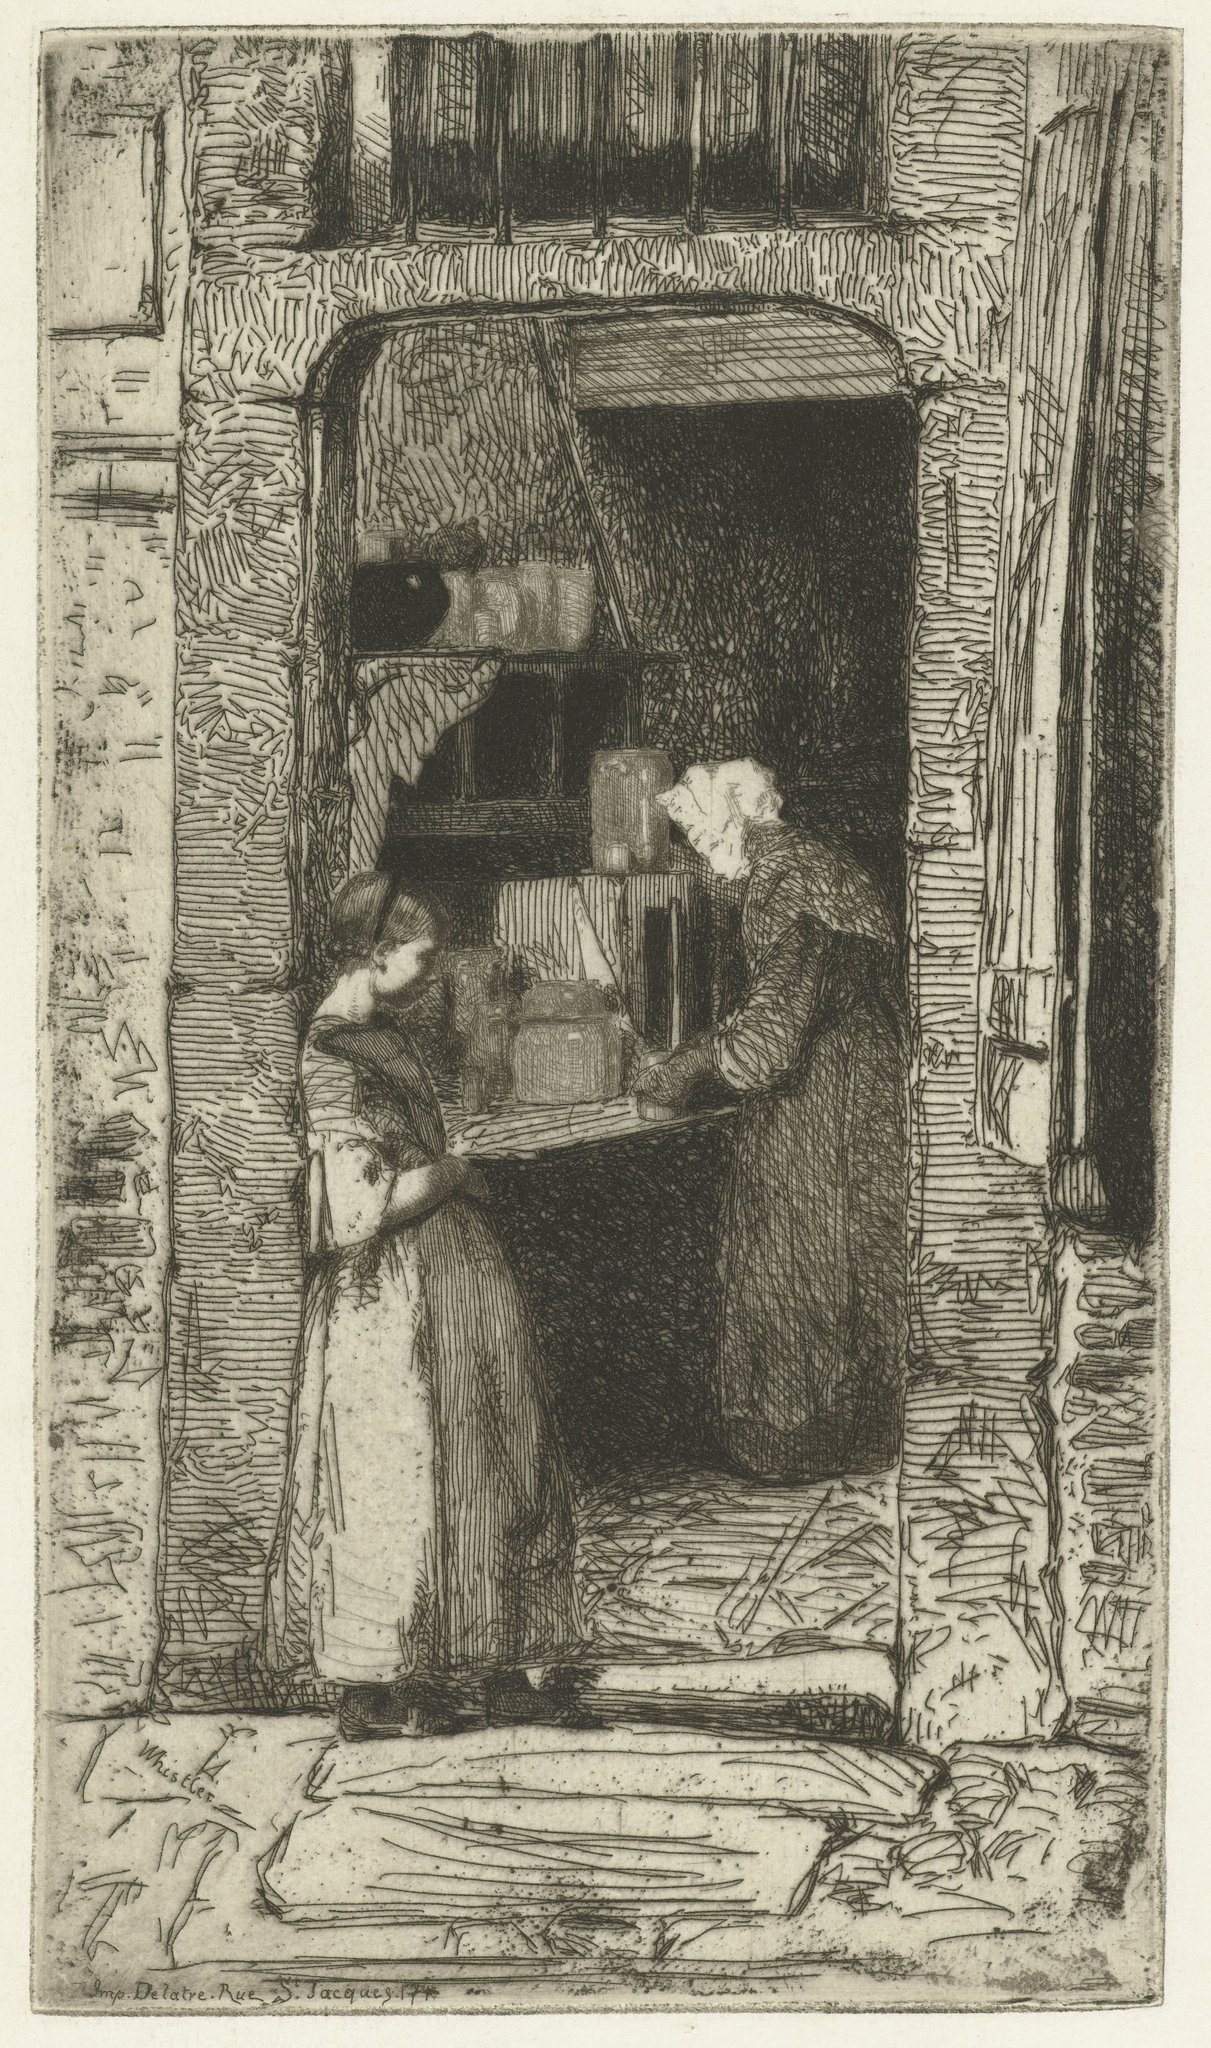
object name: print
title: La marchande de moutarde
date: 1858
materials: paper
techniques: etching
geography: paris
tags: kitchen, merchant, salesman - bb - women engaged in trade and commerce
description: In een deuropening staat een meisje, leunend tegen de deurpost. Daarachter is een vrouw in een keuken aan het werk.